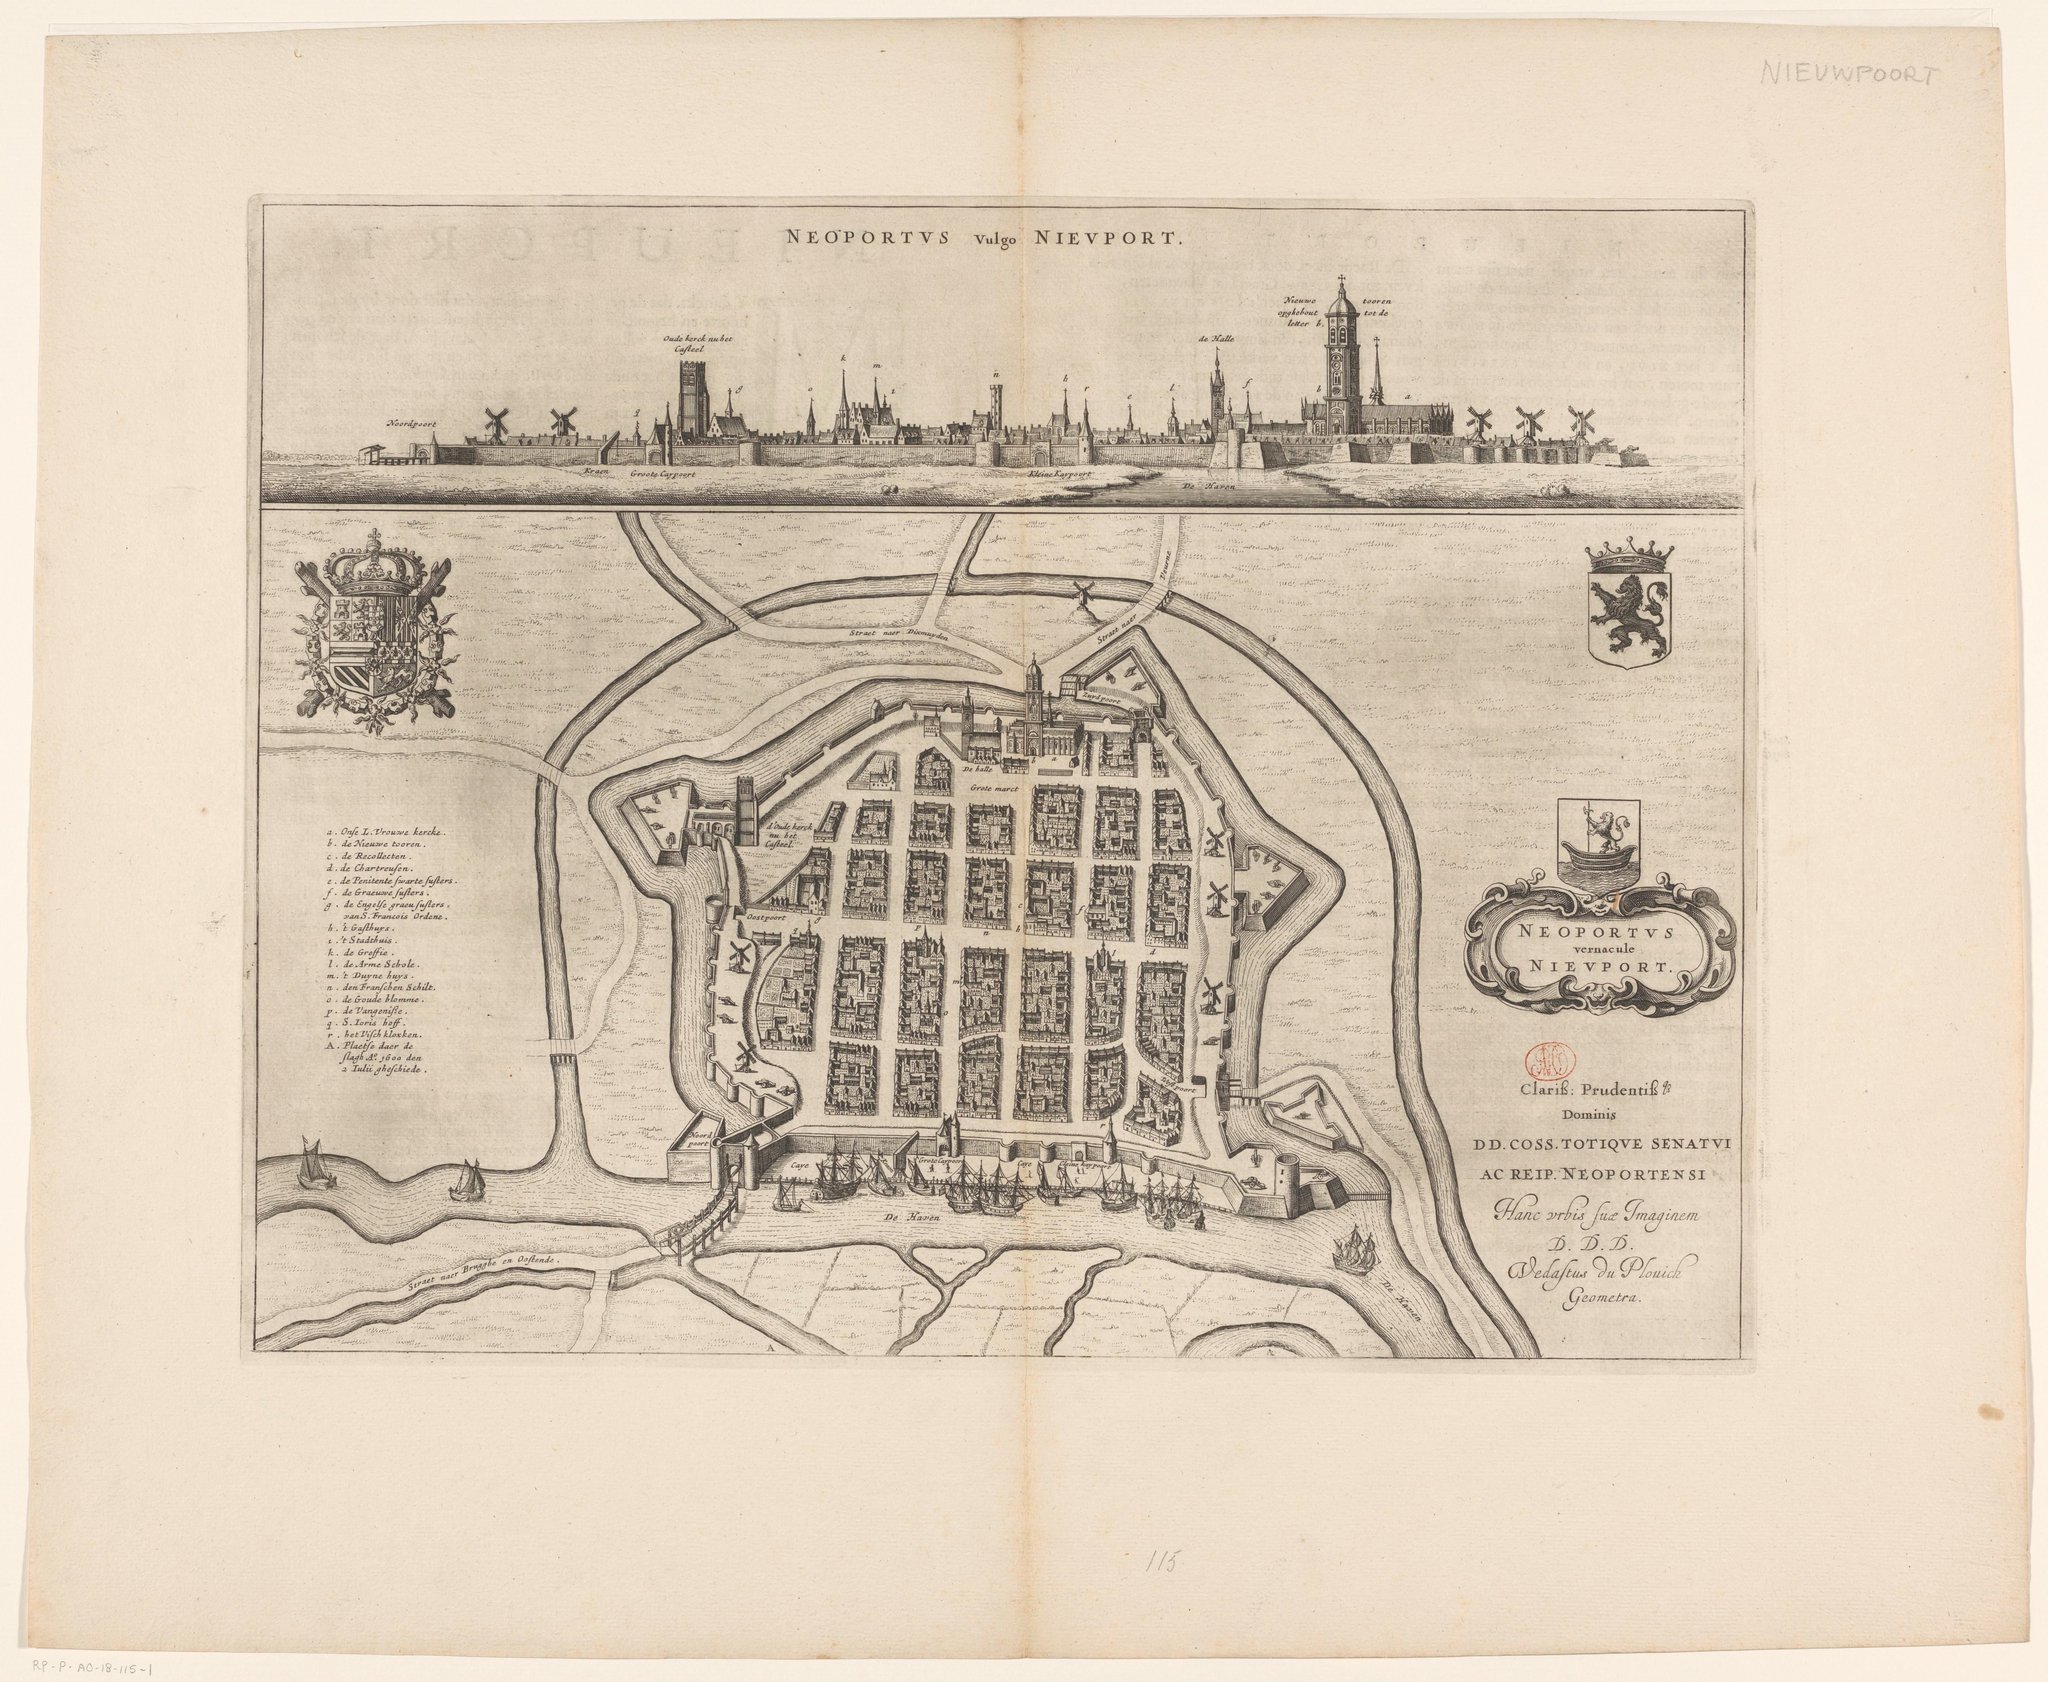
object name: print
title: Plattegrond van en gezicht op Nieuwpoort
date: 1652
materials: paper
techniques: engraving, etching, letterpress printing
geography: amsterdam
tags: coat of arms (as symbol of the state, etc.) (+ city; municipal), maps of cities, coat of arms (as symbol of the state, etc.) (+ province; provincial), prospect of city, town panorama, silhouette of city, armorial bearing, heraldry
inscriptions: collector's mark: Lugt 195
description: Boven een gezicht op Nieuwpoort. Onder een plattegrond van Nieuwpoort met gebouwen in vogelvluchtperspectief. Rechts de titelcartouche met bovenin het wapen van Nieuwpoort. Links een legenda a-r en A. Linksboven het wapen van de koning van Spanje en rechtsboven het wapen van Vlaanderen. Met Nederlandse tekst op verso.